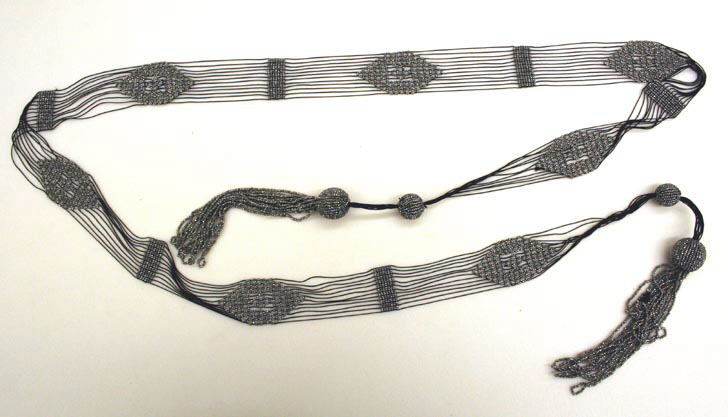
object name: belt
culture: american or european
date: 1900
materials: silk, steel